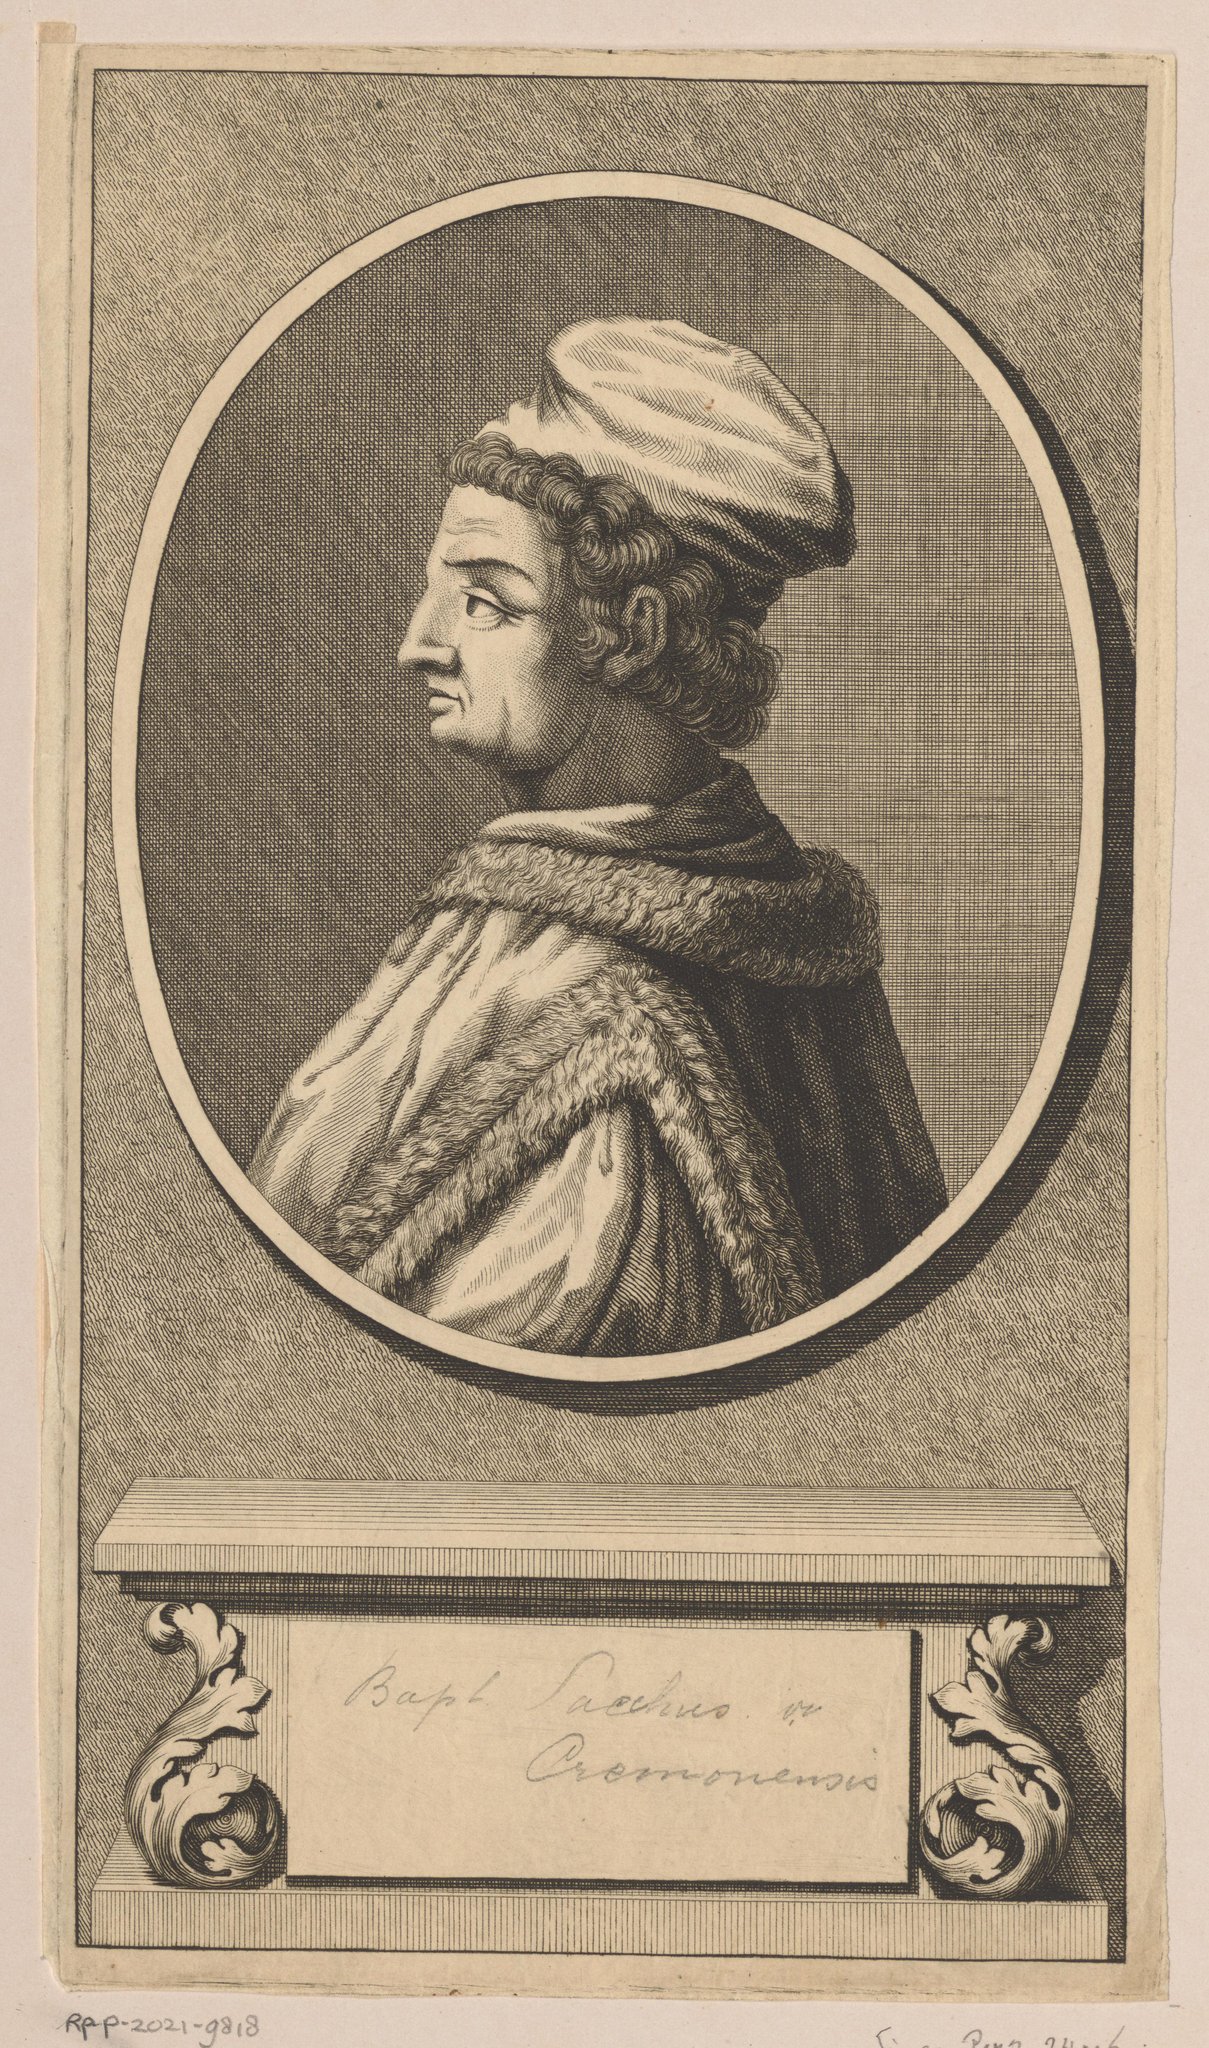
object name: print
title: Portret van Bartolomeo Platina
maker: Anonymous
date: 1722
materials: paper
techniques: engraving, etching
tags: adult man, historical persons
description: Latere staat van deze prent gebruikt in: Thesaurus antiquitatum et historiarum Italiae (...). Leiden: Pieter van der Aa, 1722.